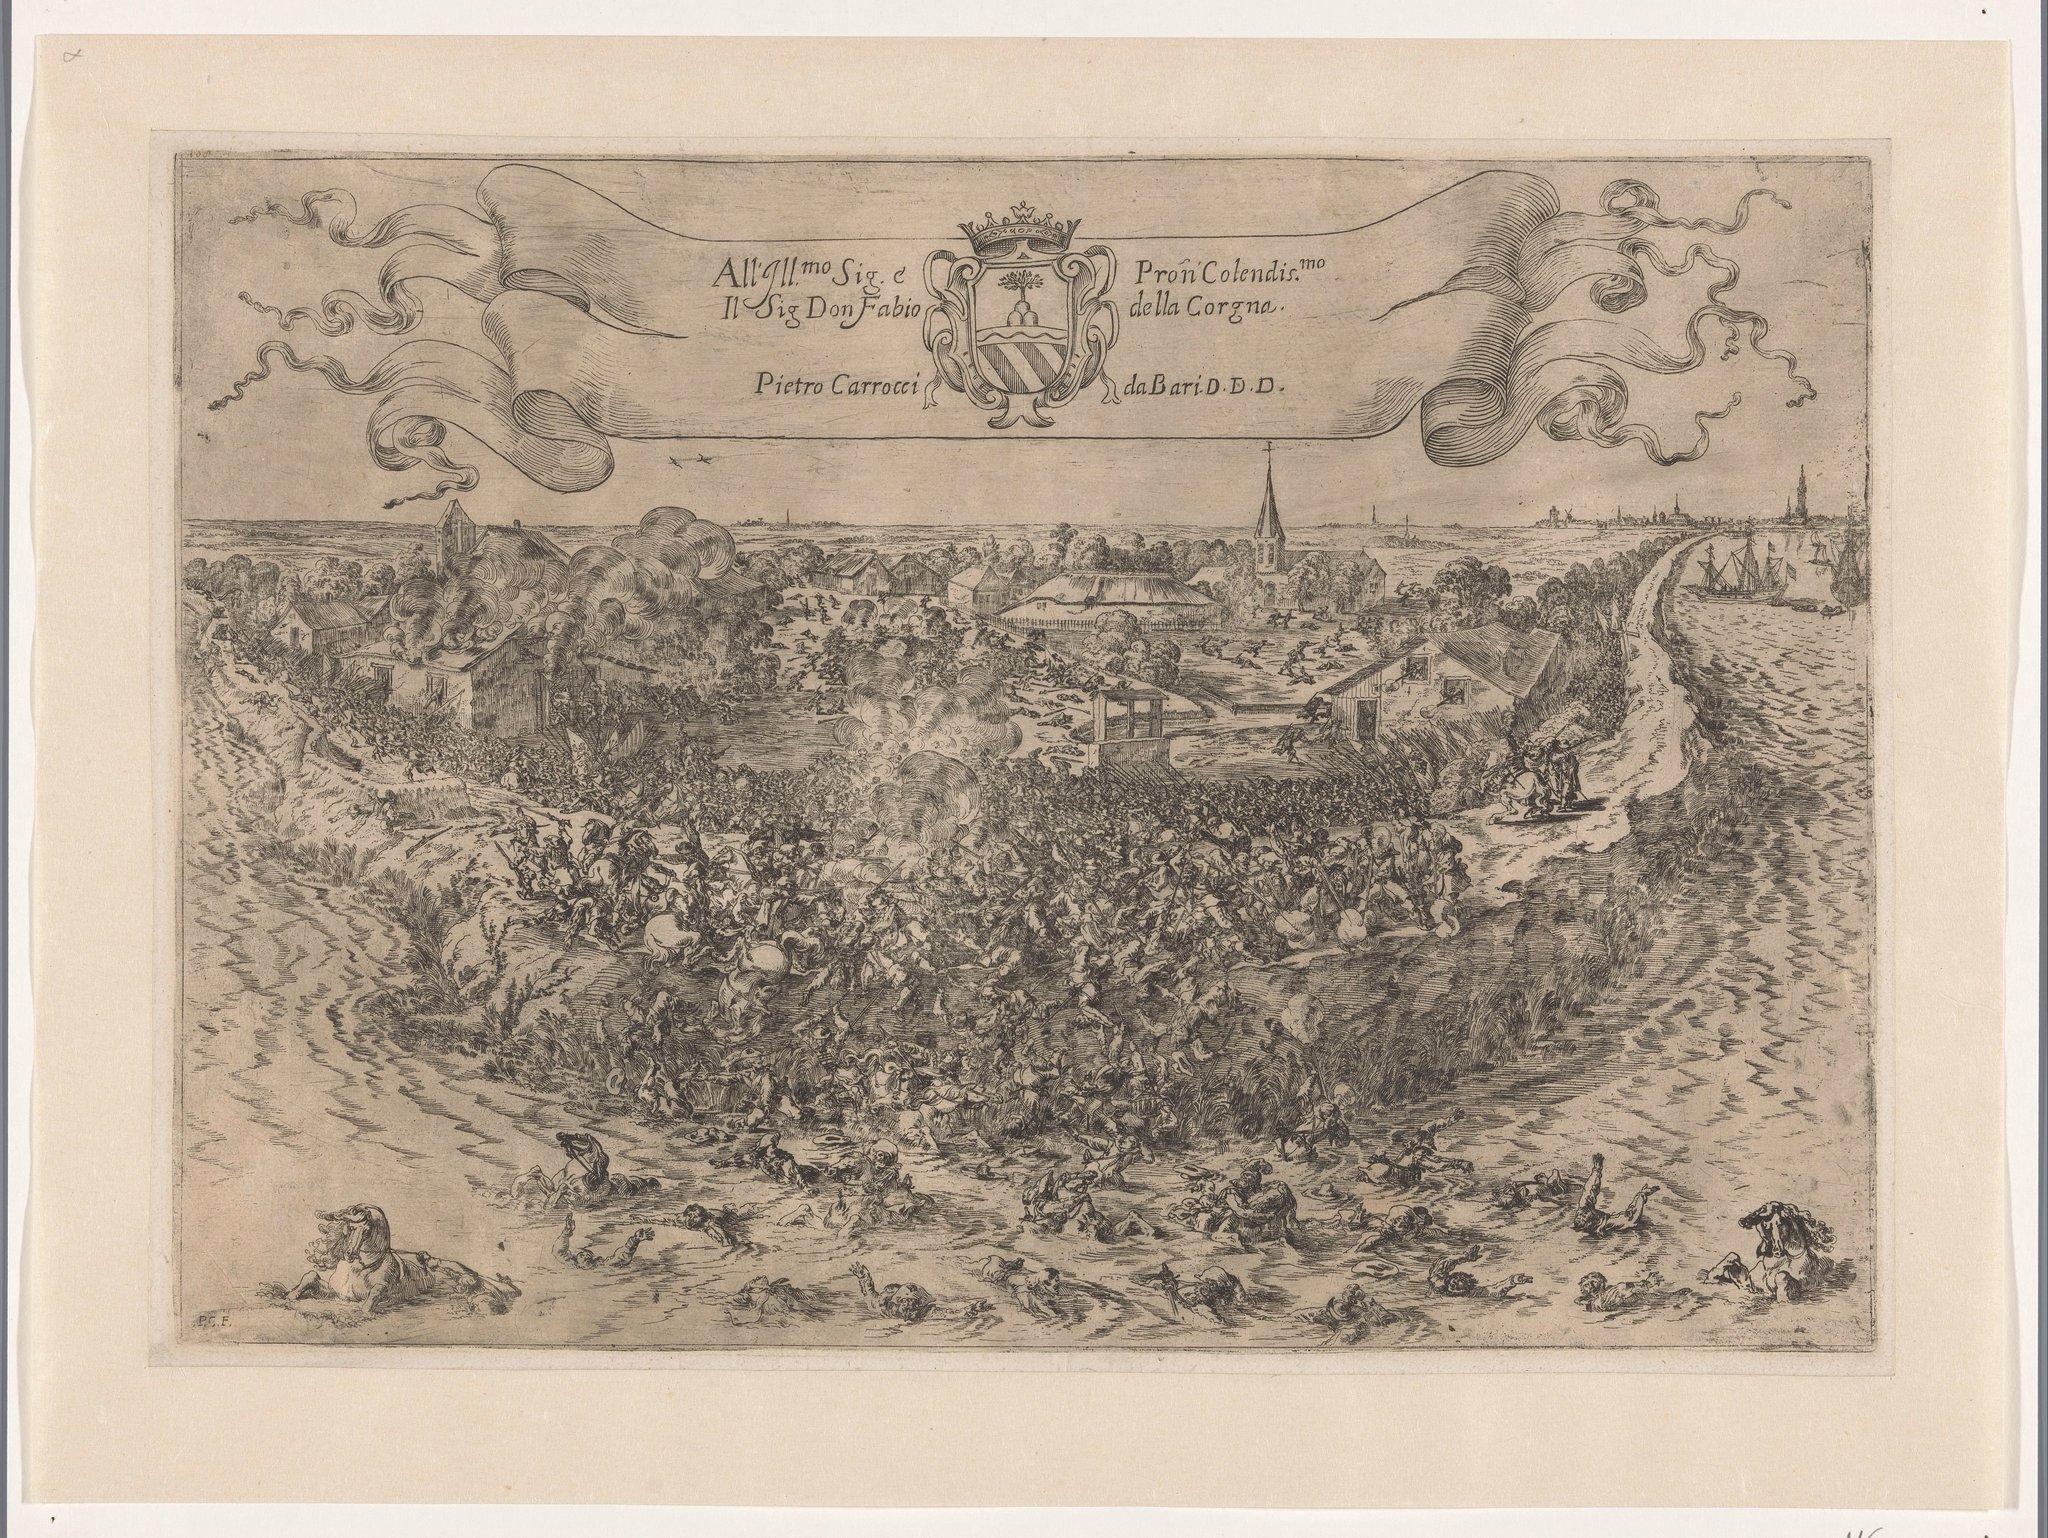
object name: print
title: Slag bij Oosterweel, 1567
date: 1637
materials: paper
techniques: engraving, etching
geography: rome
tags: brussels, battle (+ land forces), antwerp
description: De slag bij Austruweel (Oosterweel, ten noorden van Antwerpen) was het eerste treffen tussen de Spanjaarden onder Beauvoir en het Calvinistische leger (de geuzen) onder Jan van Marnix. De Spanjaarden behaalden de zege en Jan van Marnix sneuvelde in de slag. Kopie naar de prent van Baur (zie FMH 454A/1) in: F. Strada, De Bello Belgico Decas Prima Ab Excessu Caroli V Imp, Francisci Corbelletti, Rome 1632, p. 180.